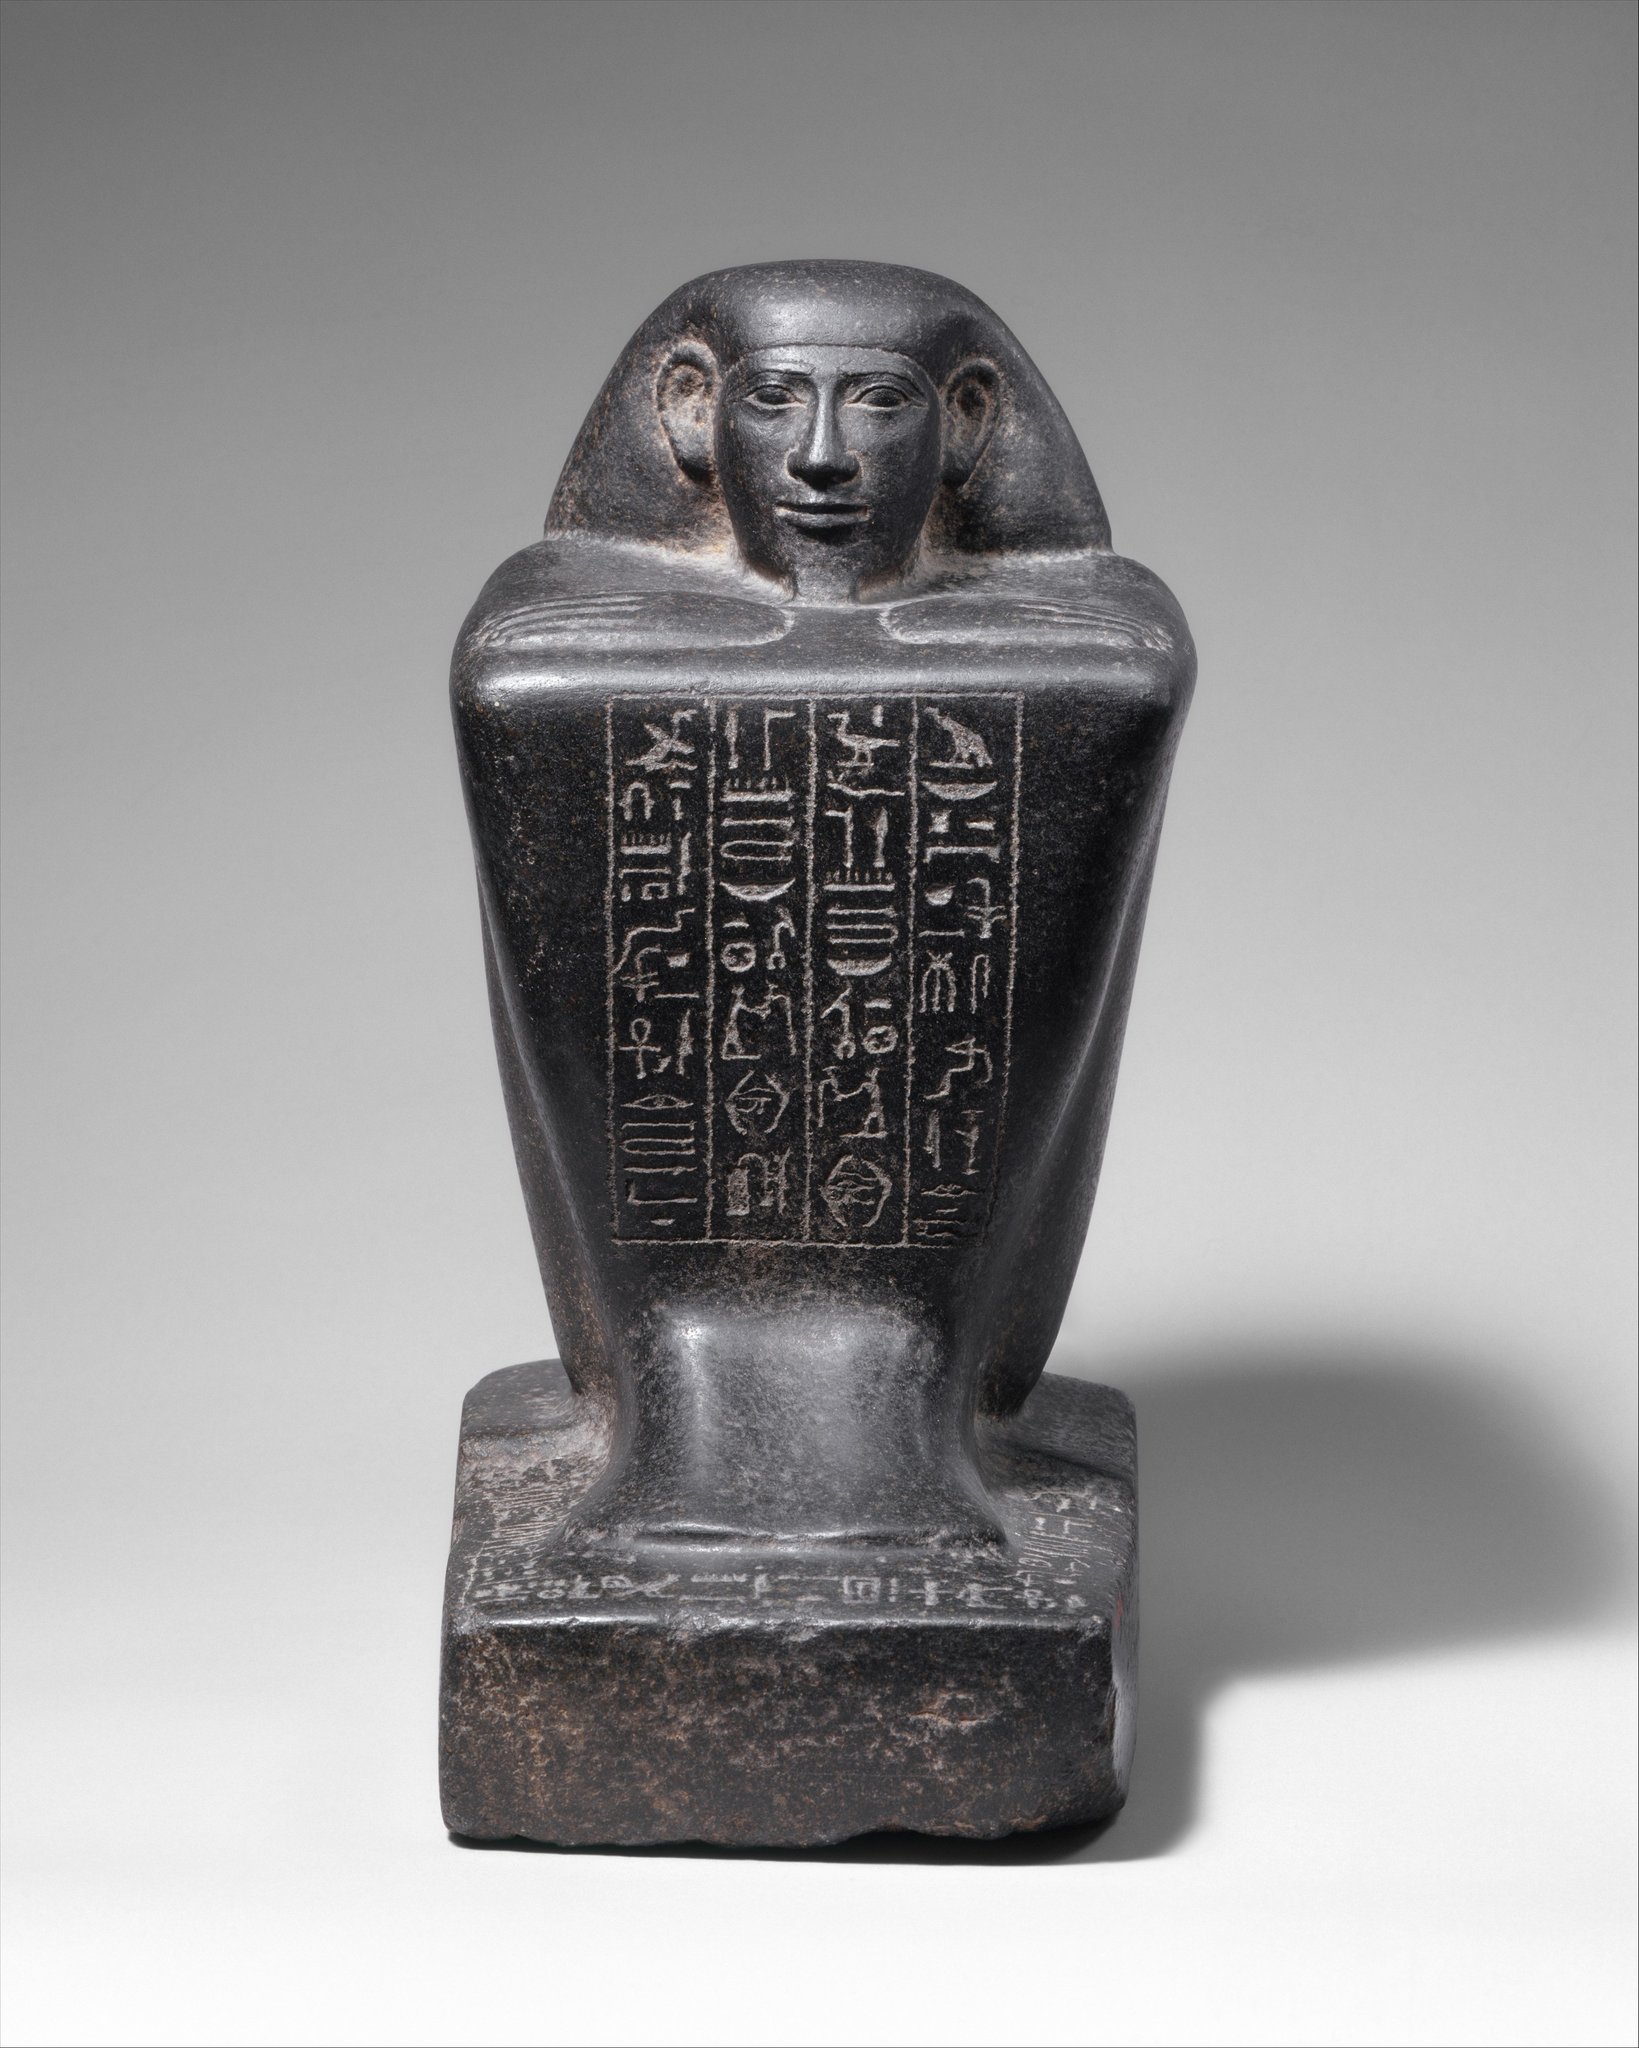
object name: block statue, djedkhonsuefankh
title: Block Statue of a Prophet of Montu and Scribe Djedkhonsuefankh, son of Khonsumes and Taat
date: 690-610 BCE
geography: upper egypt, thebes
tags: men,hieroglyphs